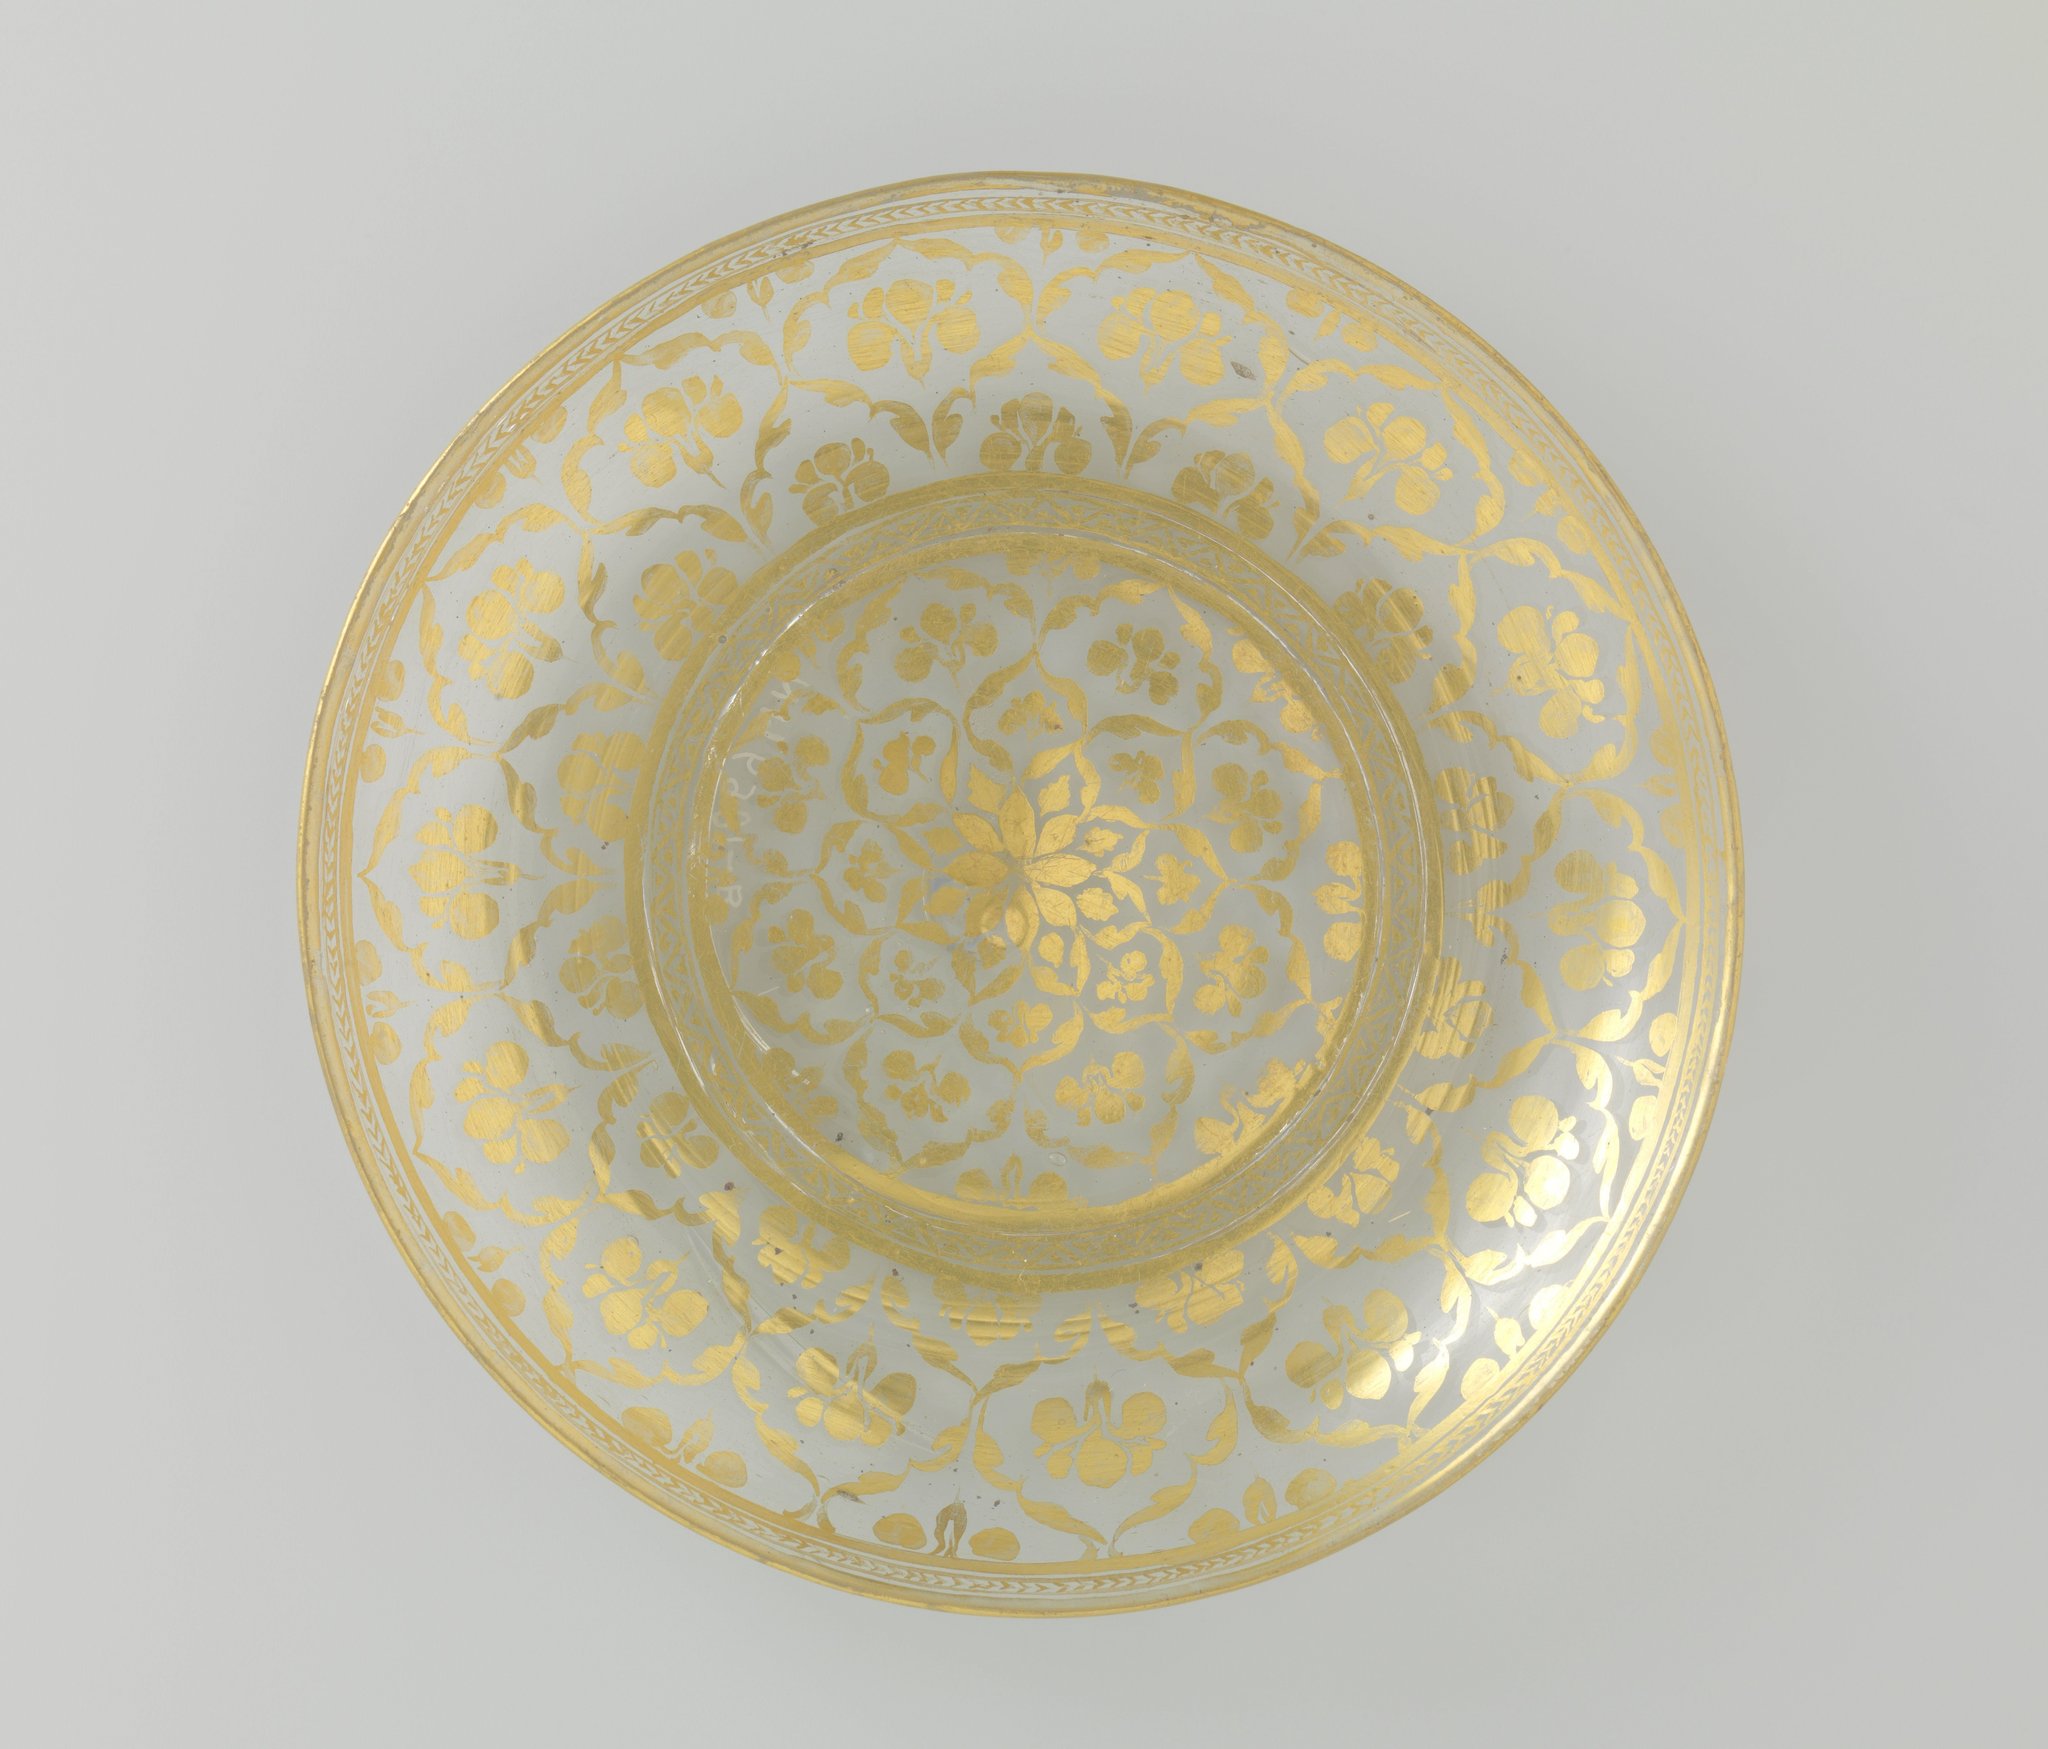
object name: platter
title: Schotel van glas met beschildering in goud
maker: Anonymous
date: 1775-1800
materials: glass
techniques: gilding, glassblowing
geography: north india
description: Bowl and saucer. North India. 1775 - 1800. Glass with green, pink and gold. J.Th. Royer bequest.